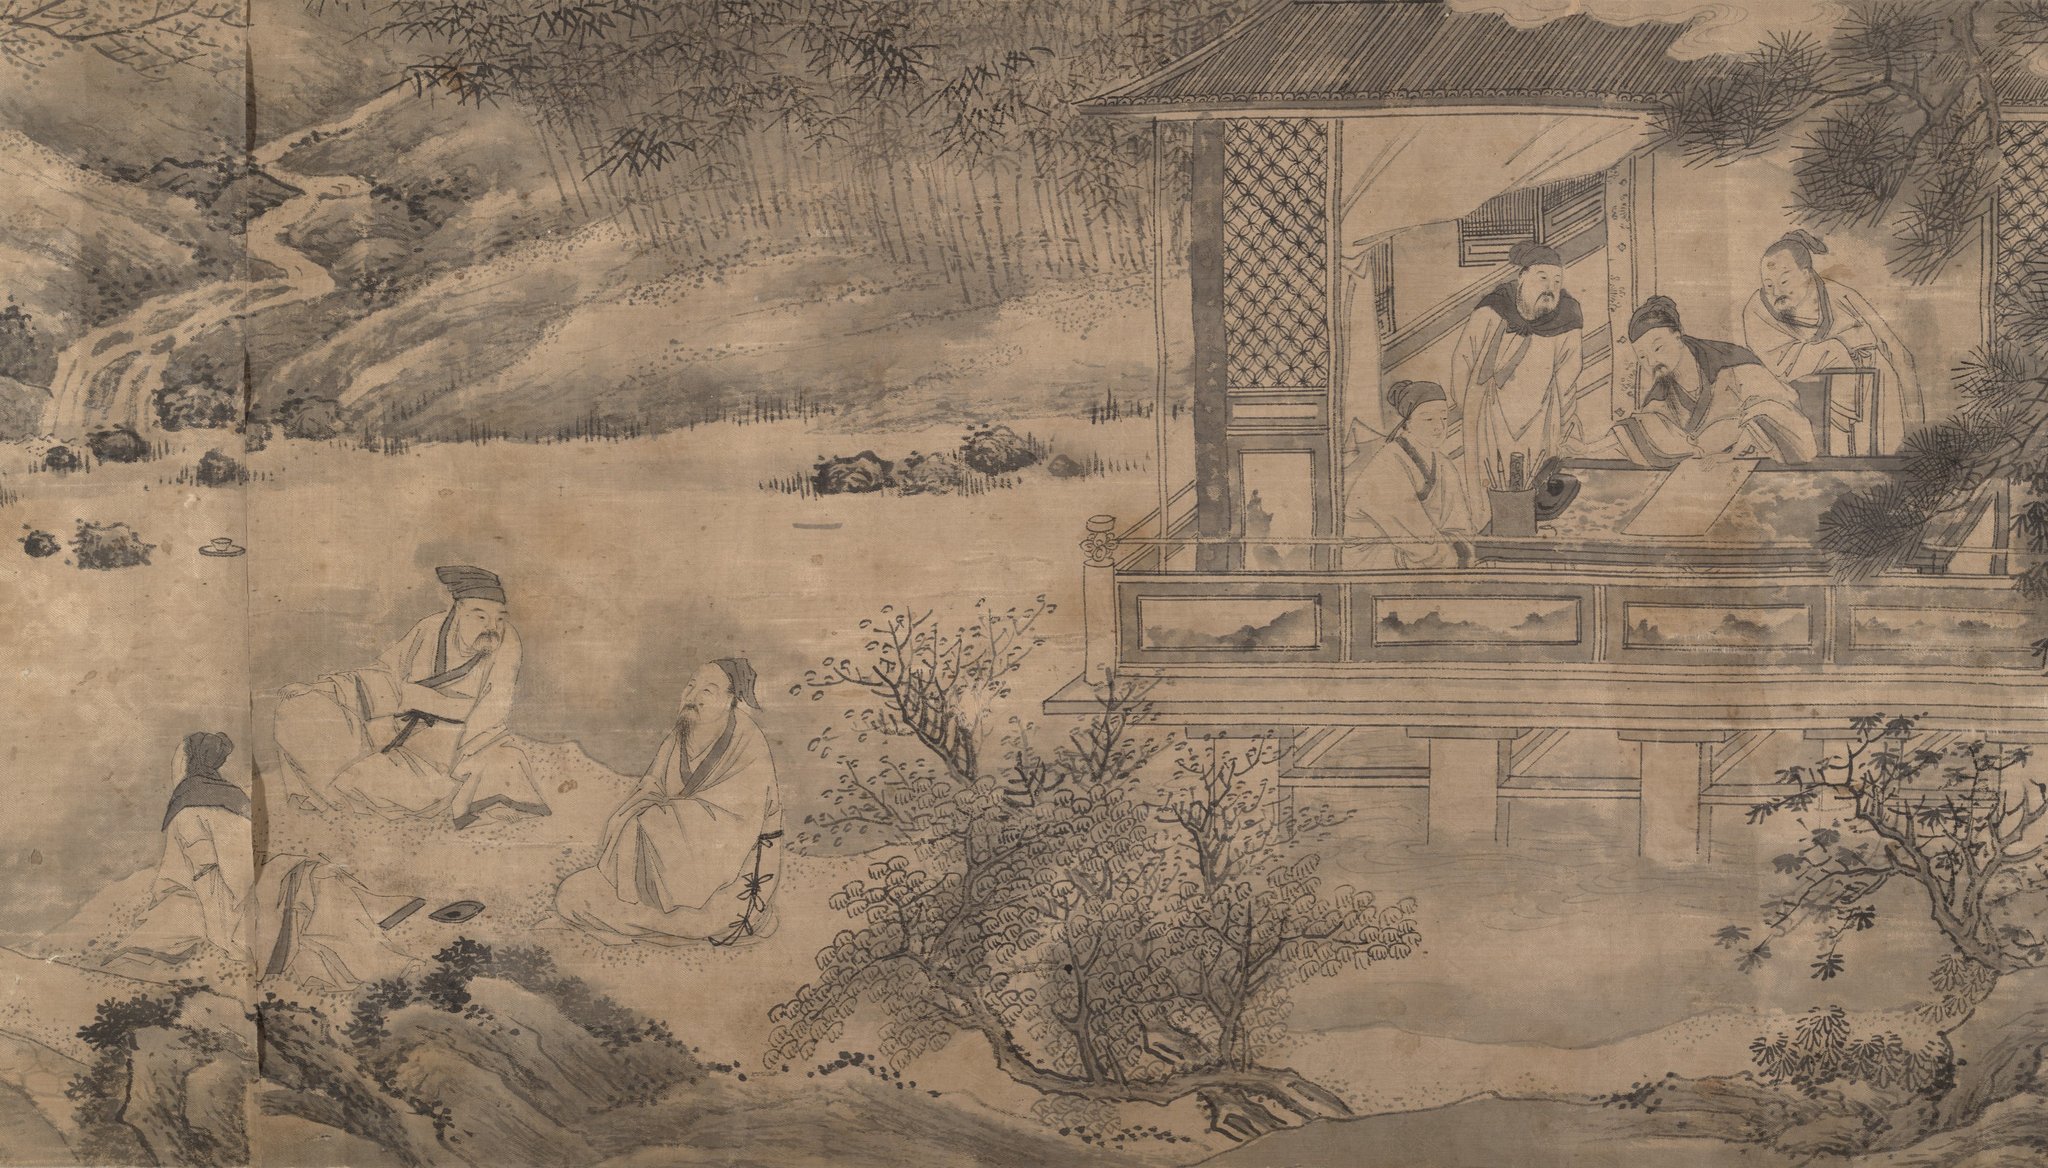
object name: handscroll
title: Gathering at the Orchid Pavilion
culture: chinese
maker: qian gong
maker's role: artist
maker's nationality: chinese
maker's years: 1573-1619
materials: ink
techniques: damask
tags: men,poets,pavilions